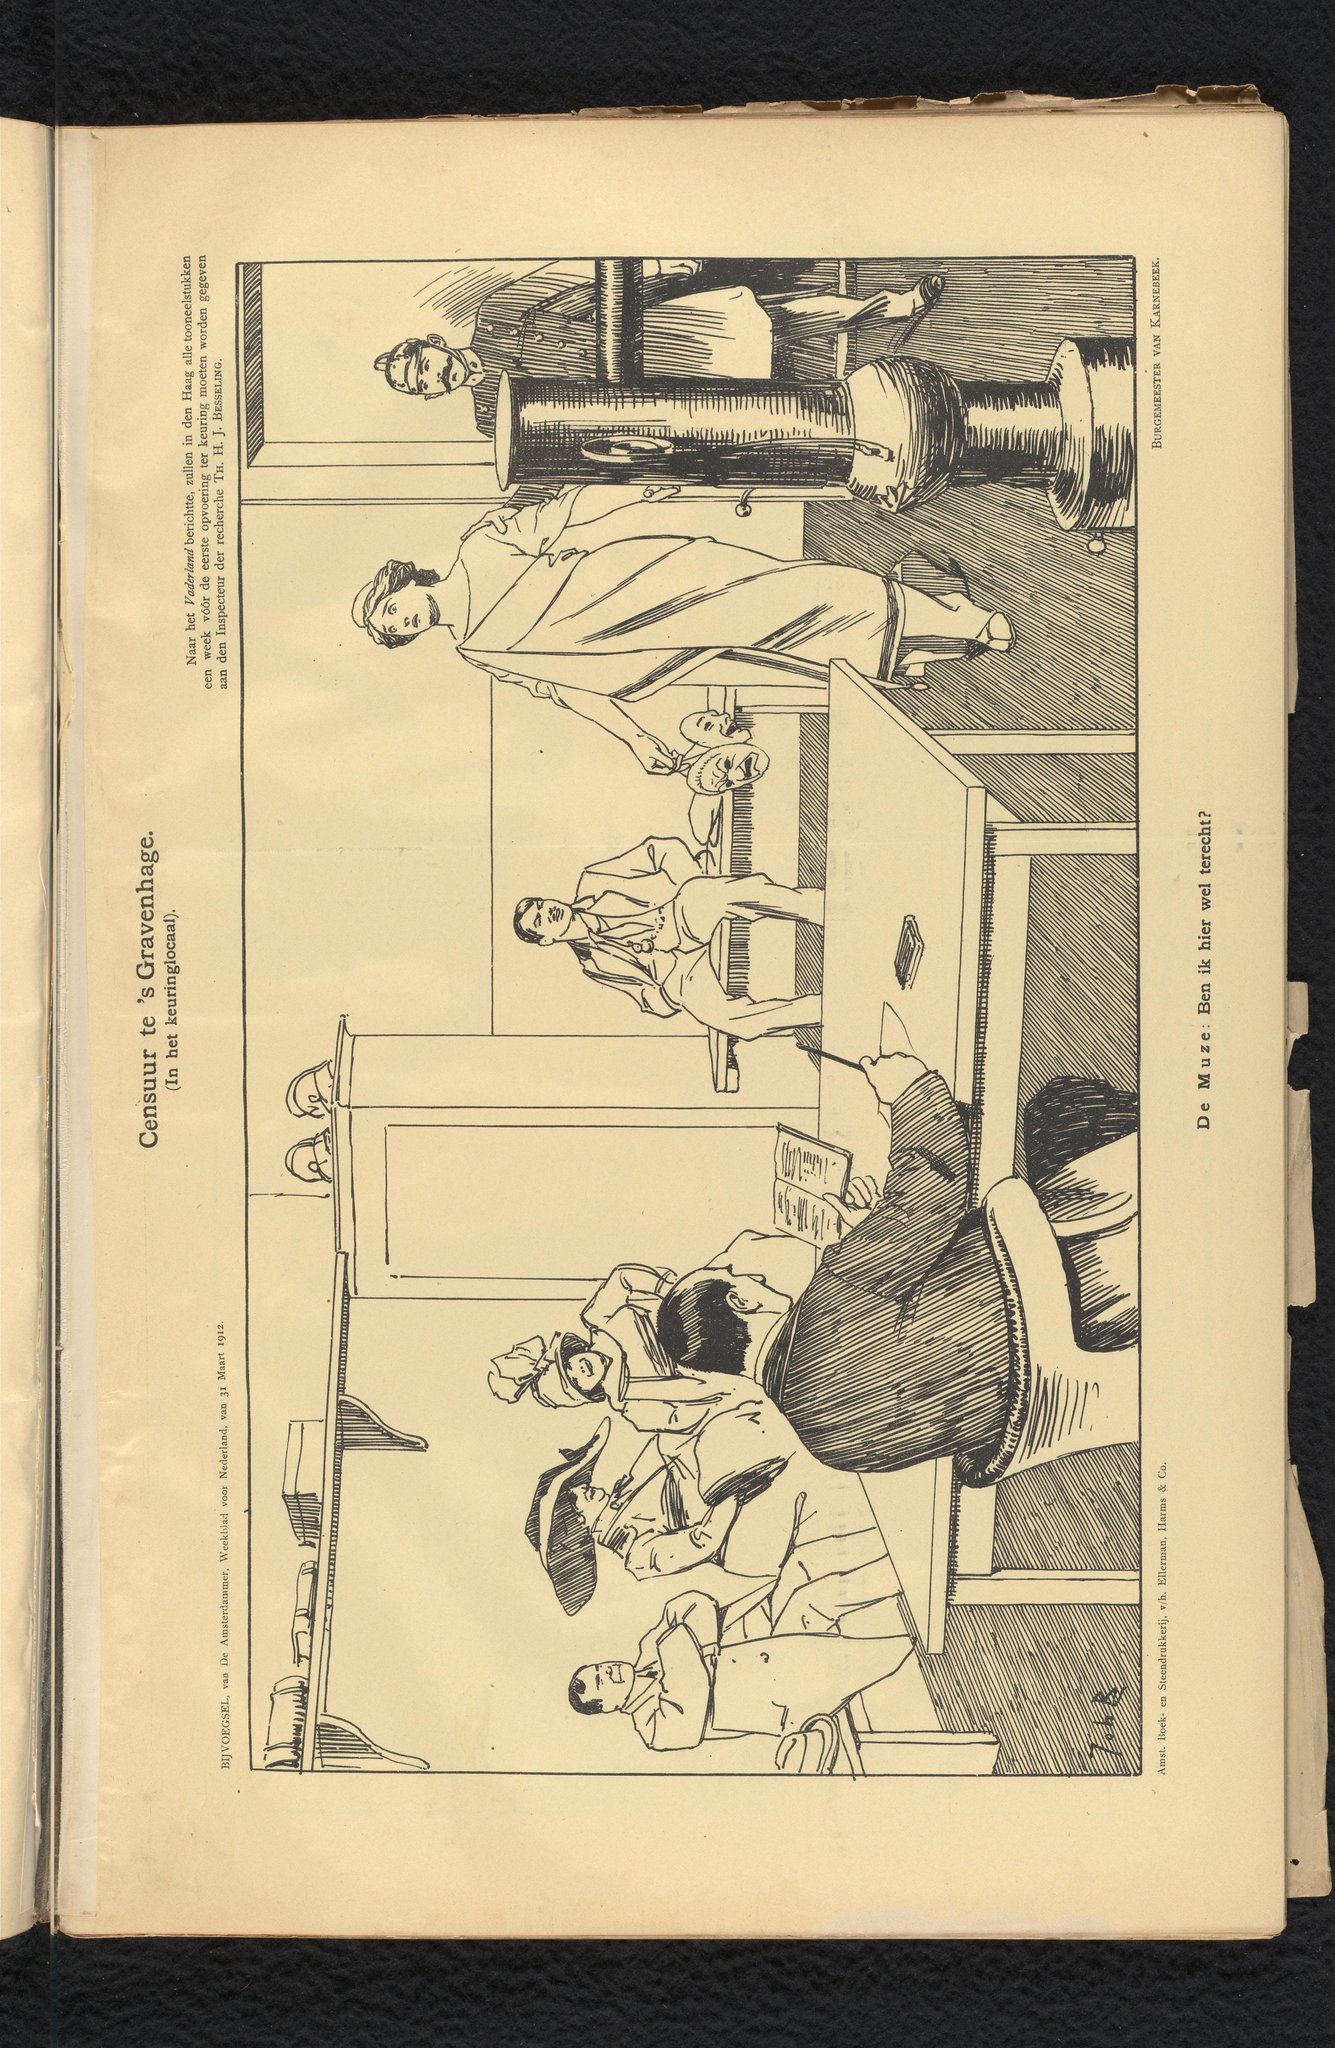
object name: cartoon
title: Censuur te 's-Gravenhage. (In het keuringlocaal)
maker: johan braakensiek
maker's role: draughtsman, print maker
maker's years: 1858-1940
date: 1912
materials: paper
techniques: lithograph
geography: amsterdam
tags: symbolic representations, allegories and emblems ~ the arts of the stage, censorship, single muses, political caricatures and satires, police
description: De muze van de toneelkunst door een politieagent op het bureau voorgeleid bij Th. H.J. Besseling, de inspecteur van de recherche in Den Haag, voor keuring van de toneelstukken.